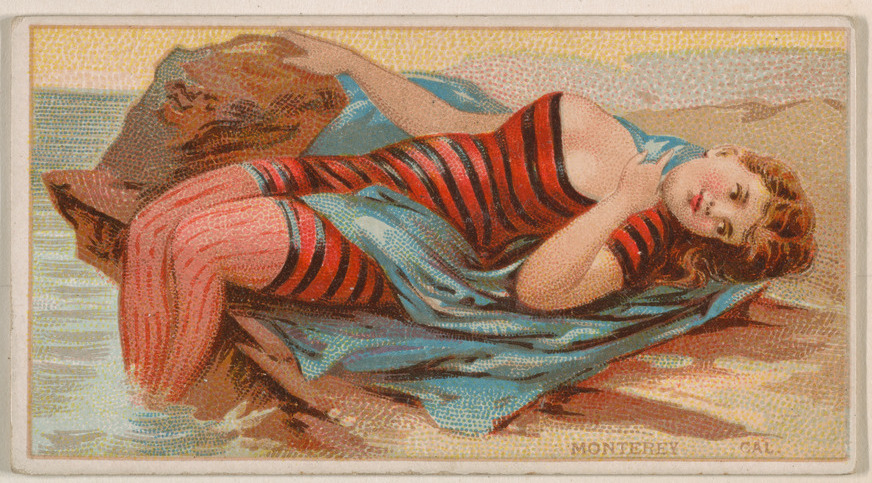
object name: print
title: Monterey, California, from the Surf Beauties series (N232), issued by Kinney Bros.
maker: kinney brothers tobacco company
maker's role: publisher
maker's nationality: american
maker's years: 1869-2011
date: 1889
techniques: color lithograph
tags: women